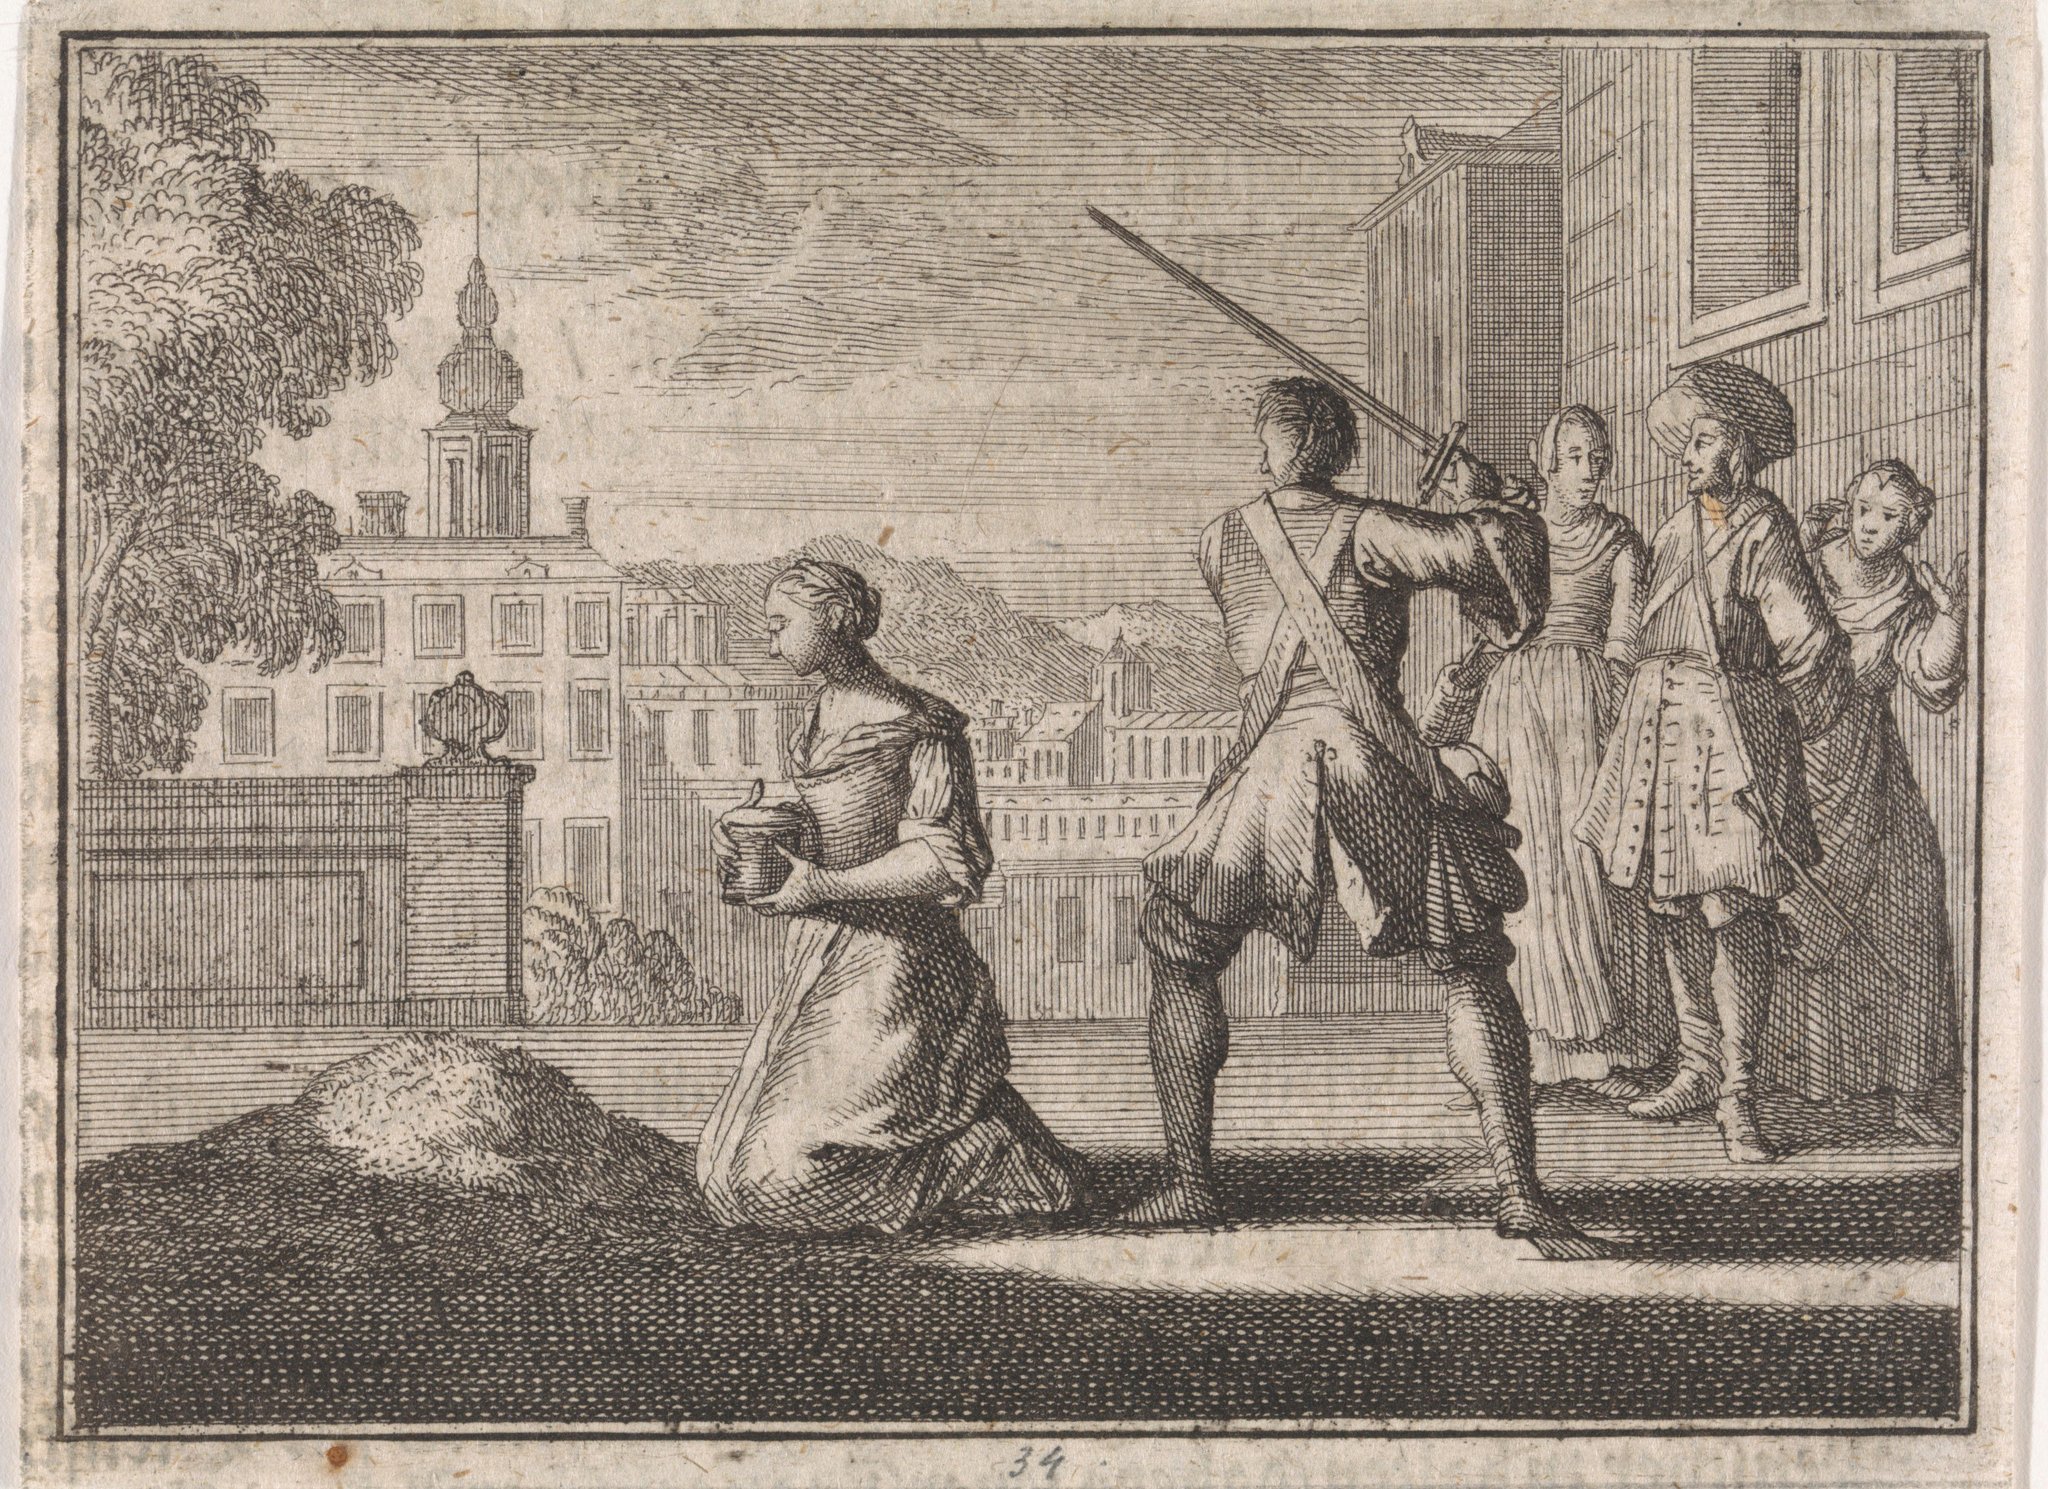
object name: book illustration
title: Die Jungfrauen seynd nix werth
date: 1710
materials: paper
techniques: etching, letterpress printing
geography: nuremberg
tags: violent death by beheading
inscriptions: collector's mark: Lugt 2228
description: Illustratie uit: Abraham a Sancta Clara. Heilsames Gemisch Gemasch, das ist: Allerley seltsame und verwunderliche Geschichten (...). Neurenberg: Christoph Weigel, 1710, p. 329.